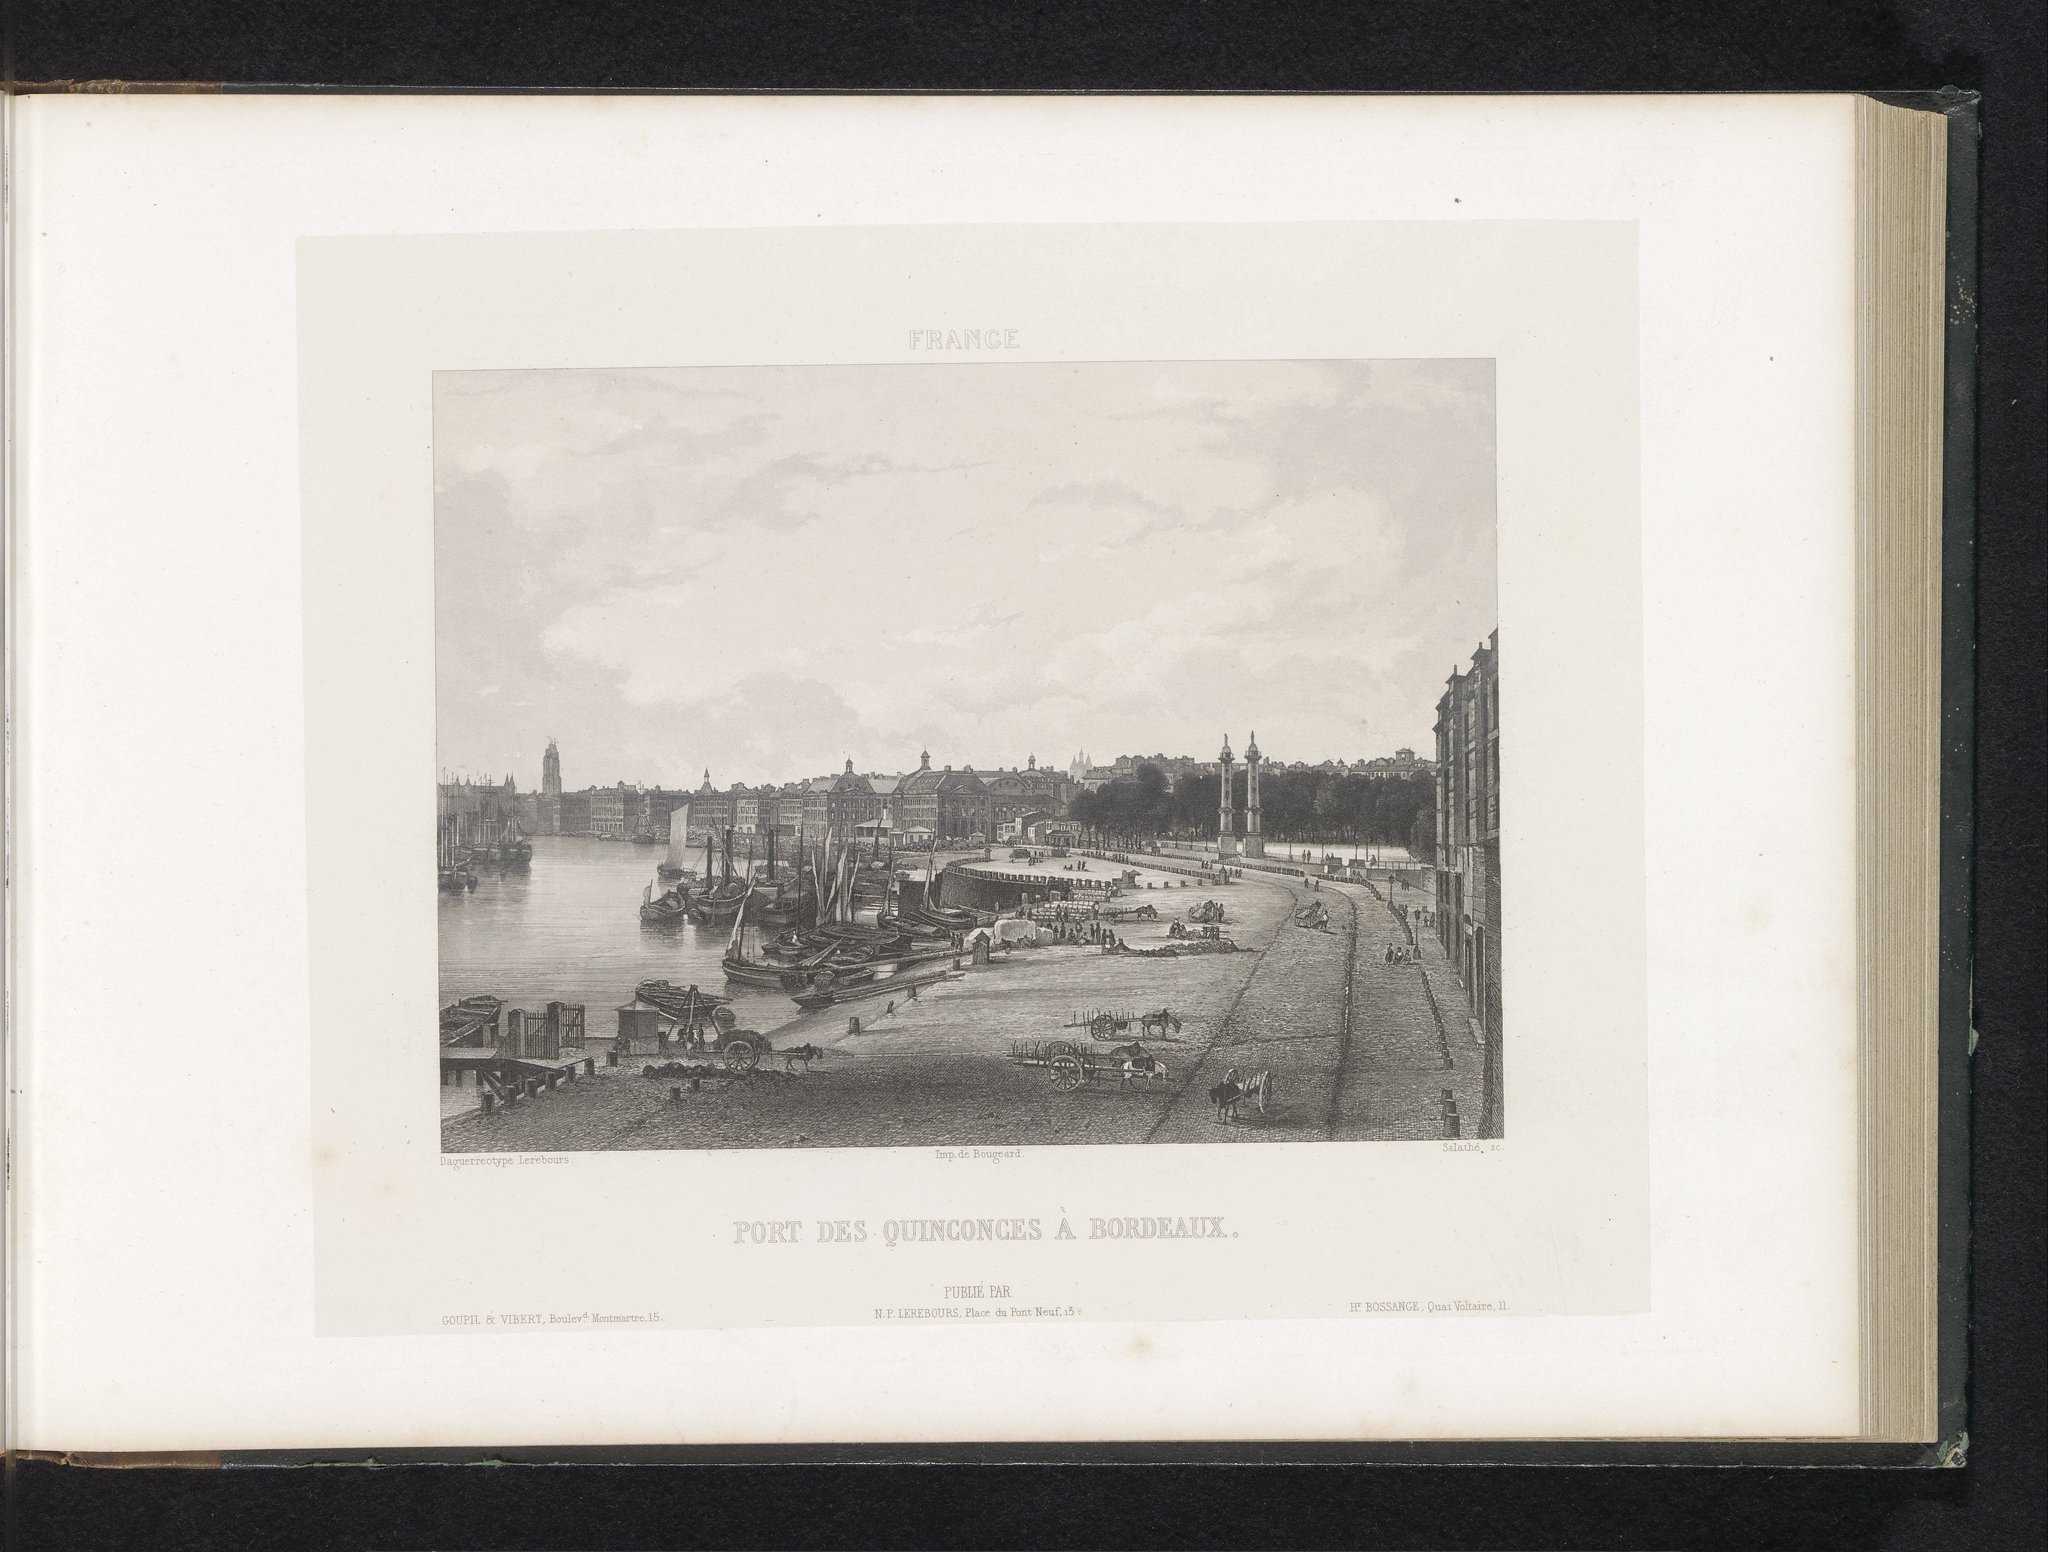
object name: print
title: Gezicht op een haven te Bordeaux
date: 1839-1841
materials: paper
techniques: aquatint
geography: paris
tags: harbour, city-view in general; 'veduta'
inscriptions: inscription: ‘N.P. Lerebours Place du Pont Neuf 15’, inscription: ‘Rittner & Goupil Boulevd Montmartre 15’, inscription: ‘Hr. Bossance Quai Voltaire 11’